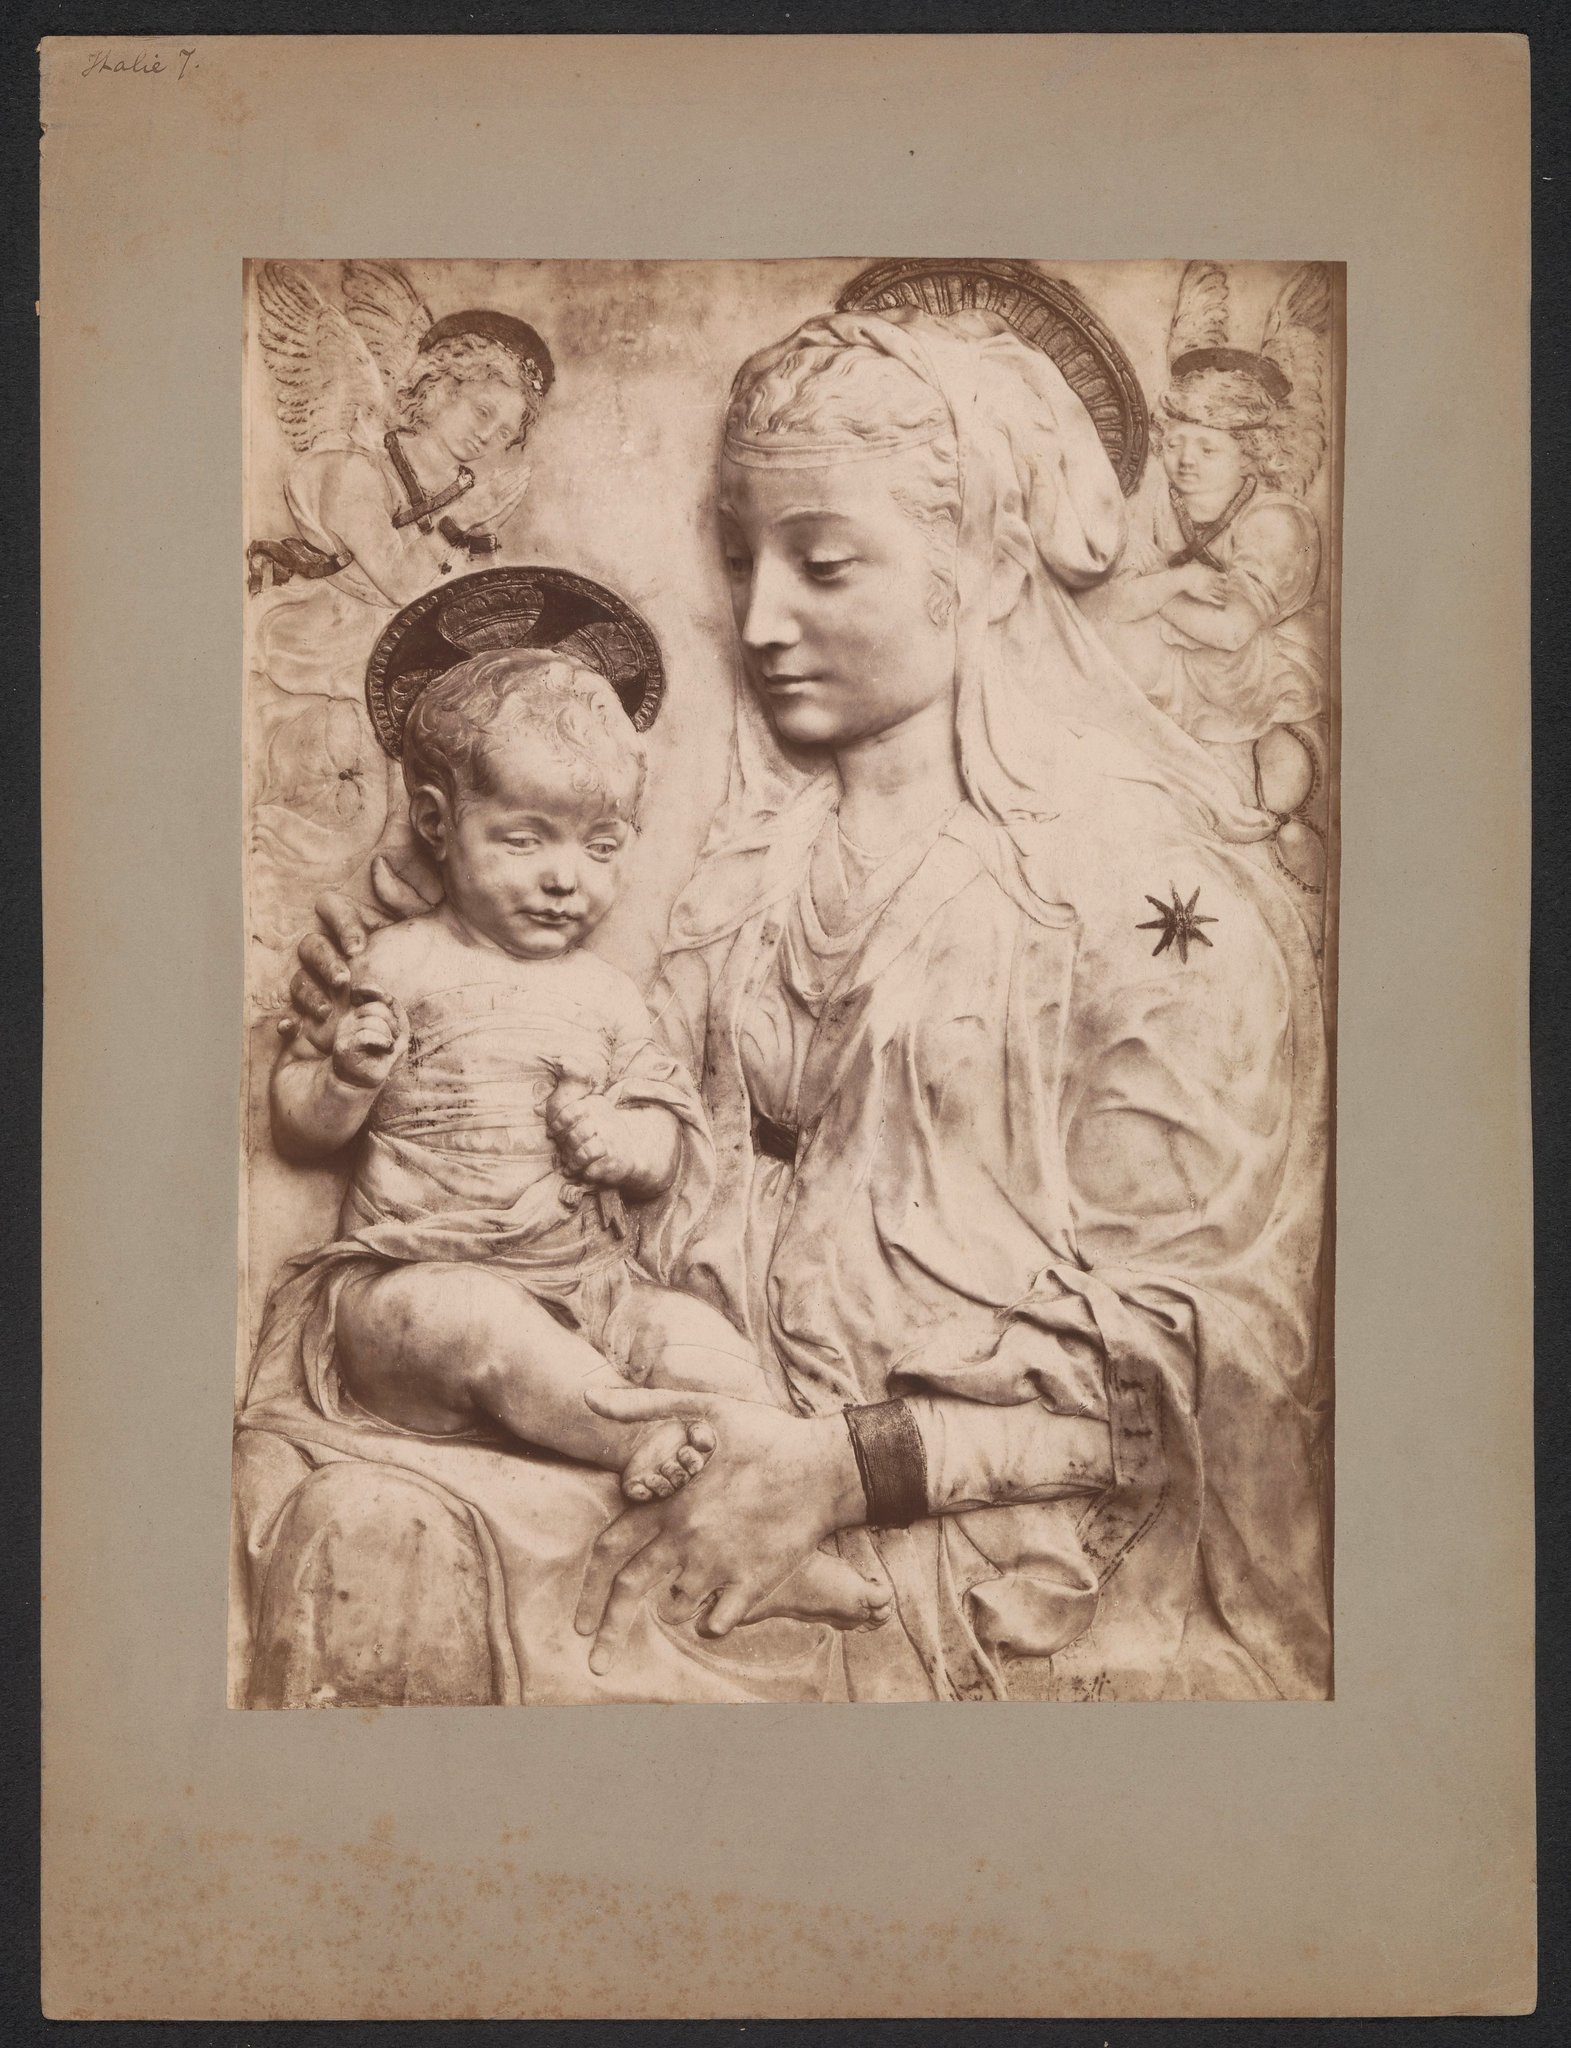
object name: photograph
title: Reliëf van Maria met Christus als kind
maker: Anonymous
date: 1850-1900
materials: cardboard, photographic support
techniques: albumen print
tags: mary sitting or enthroned, the christ-child sitting on her knee (christ-child to mary's left), sculpture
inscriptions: annotation: ‘Madonna met het kind/ Florentijnse school’, collector's mark: ‘RIJKS NORMAALSCHOOL voor T[EEKENONDERWIJZERS] AMSTERDAM’, annotation: ‘Italië 7.’